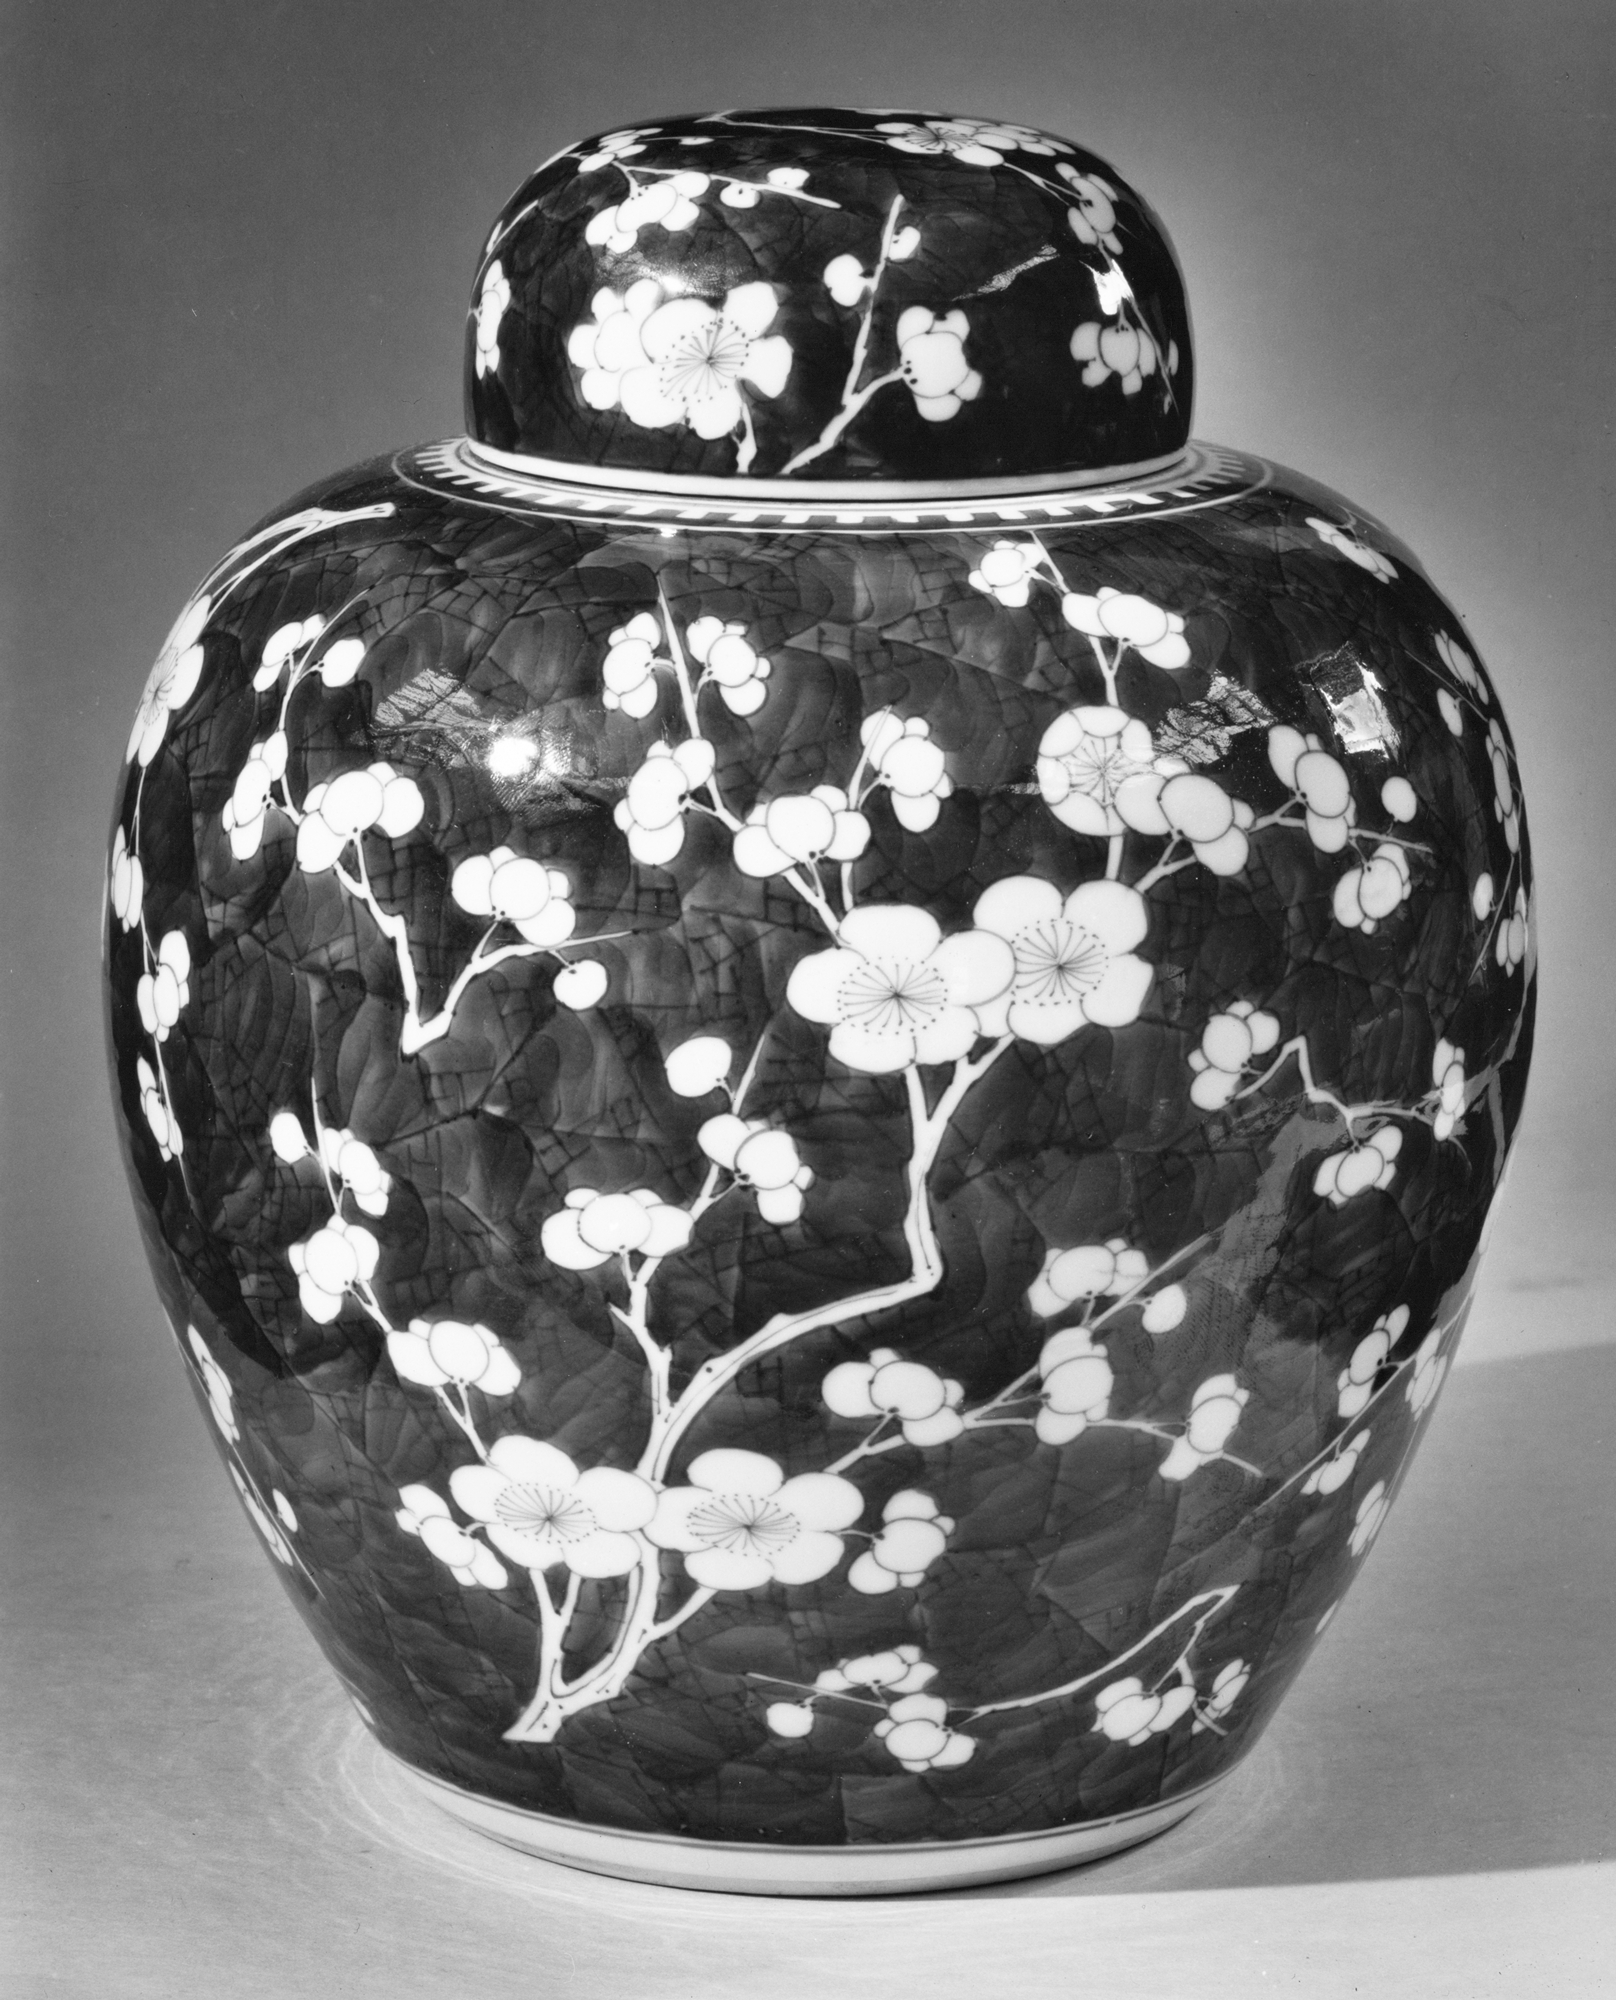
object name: covered jar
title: Covered jar with plum blossoms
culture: chinese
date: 1667-1733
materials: cobalt, porcelain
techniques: painting, underglaze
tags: flowers